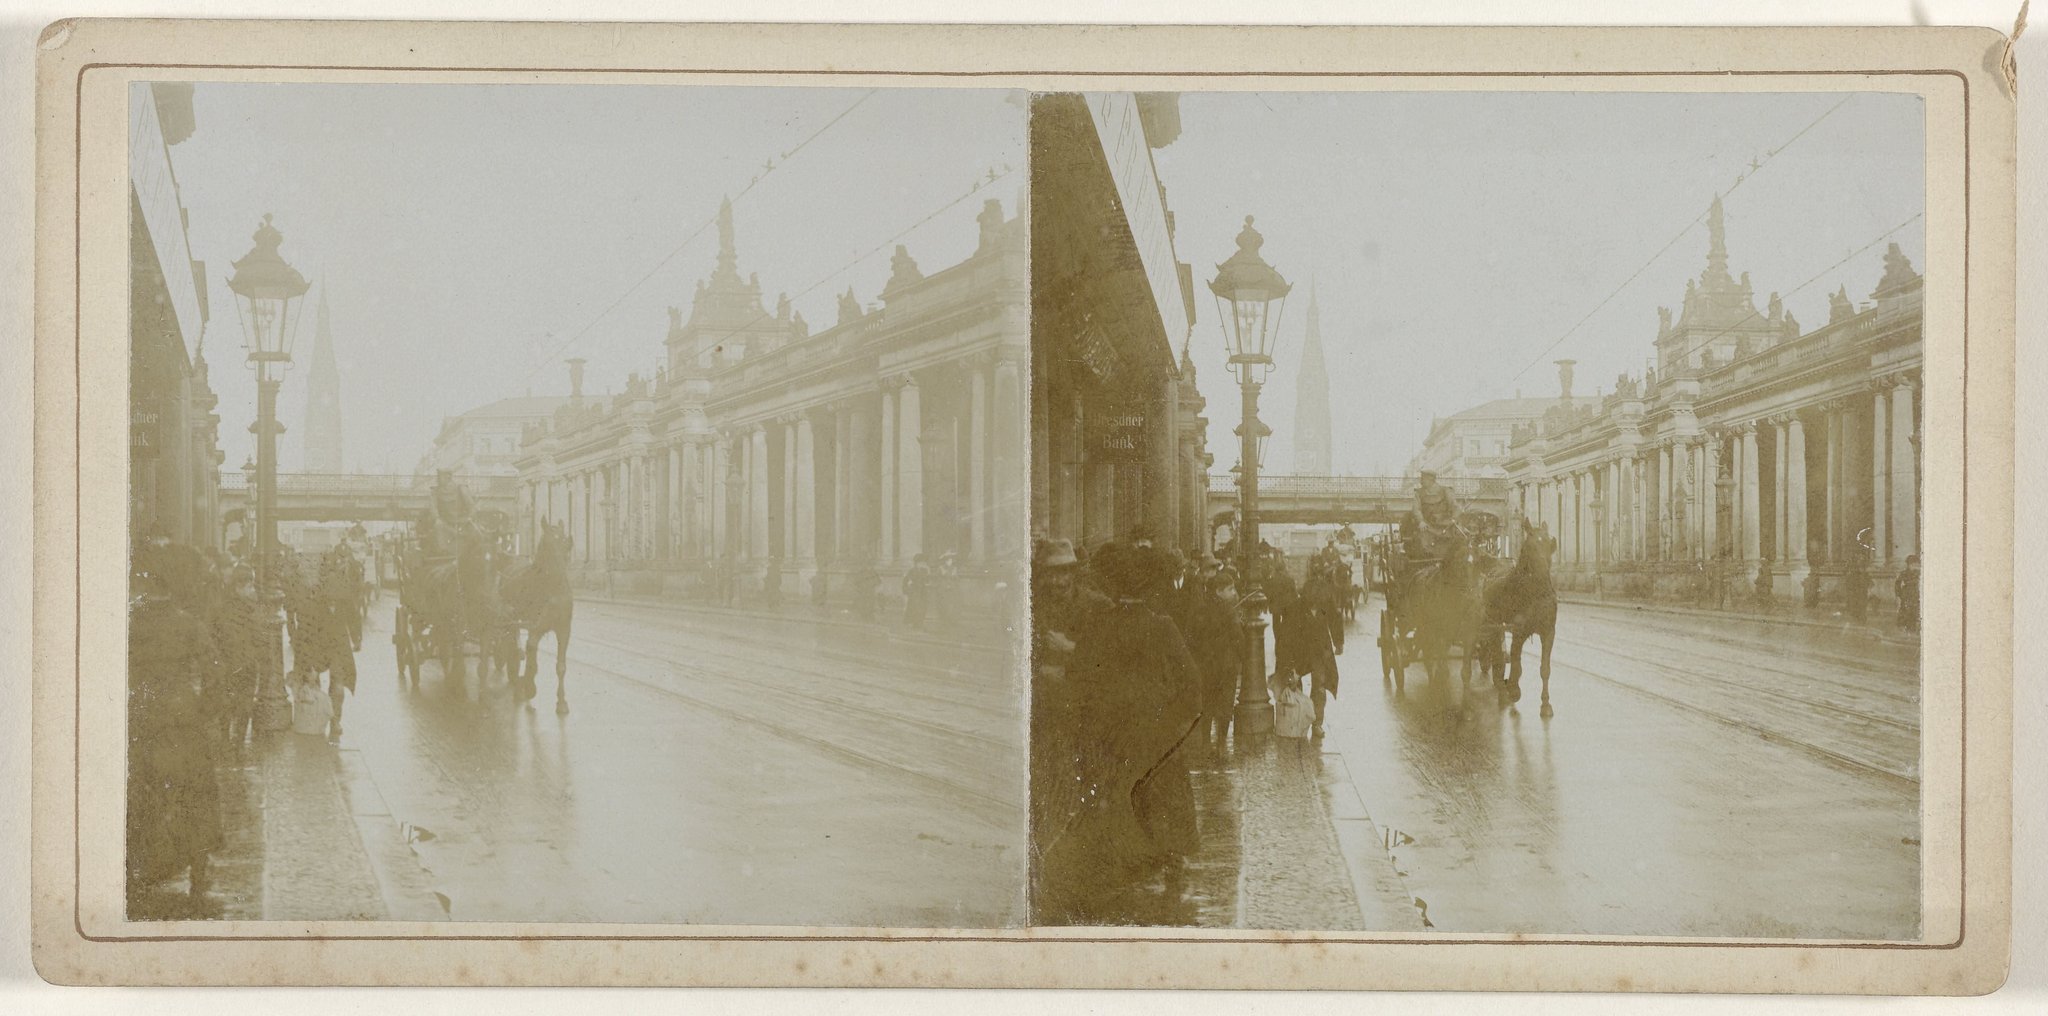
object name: stereograph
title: Königstrasse in Berlijn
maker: geldolph adriaan kessler (dolph)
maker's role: fotograaf, industrieel, voetballer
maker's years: 1884-1945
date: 1903-1910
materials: cardboard, paper, photographic support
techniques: collodion silver print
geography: berlin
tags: berlin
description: Königskolonnaden in de Königstrasse (tegenwoordig Rathausstrasse) nabij station Alexanderplatz met de Georgenkirche op de achtergrond.